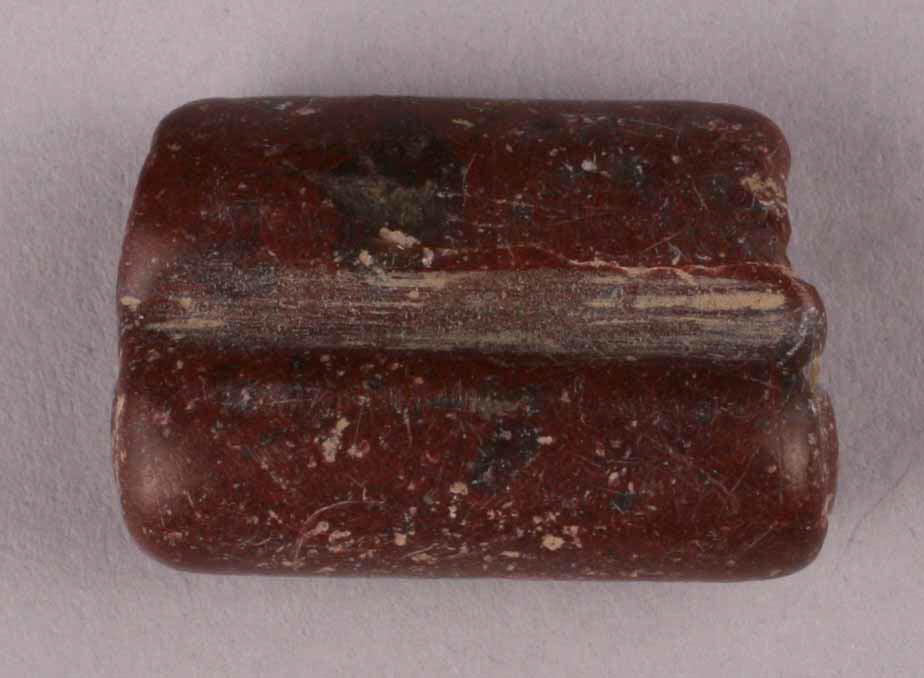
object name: bead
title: Beads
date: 801-1200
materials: stone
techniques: cutting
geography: iran